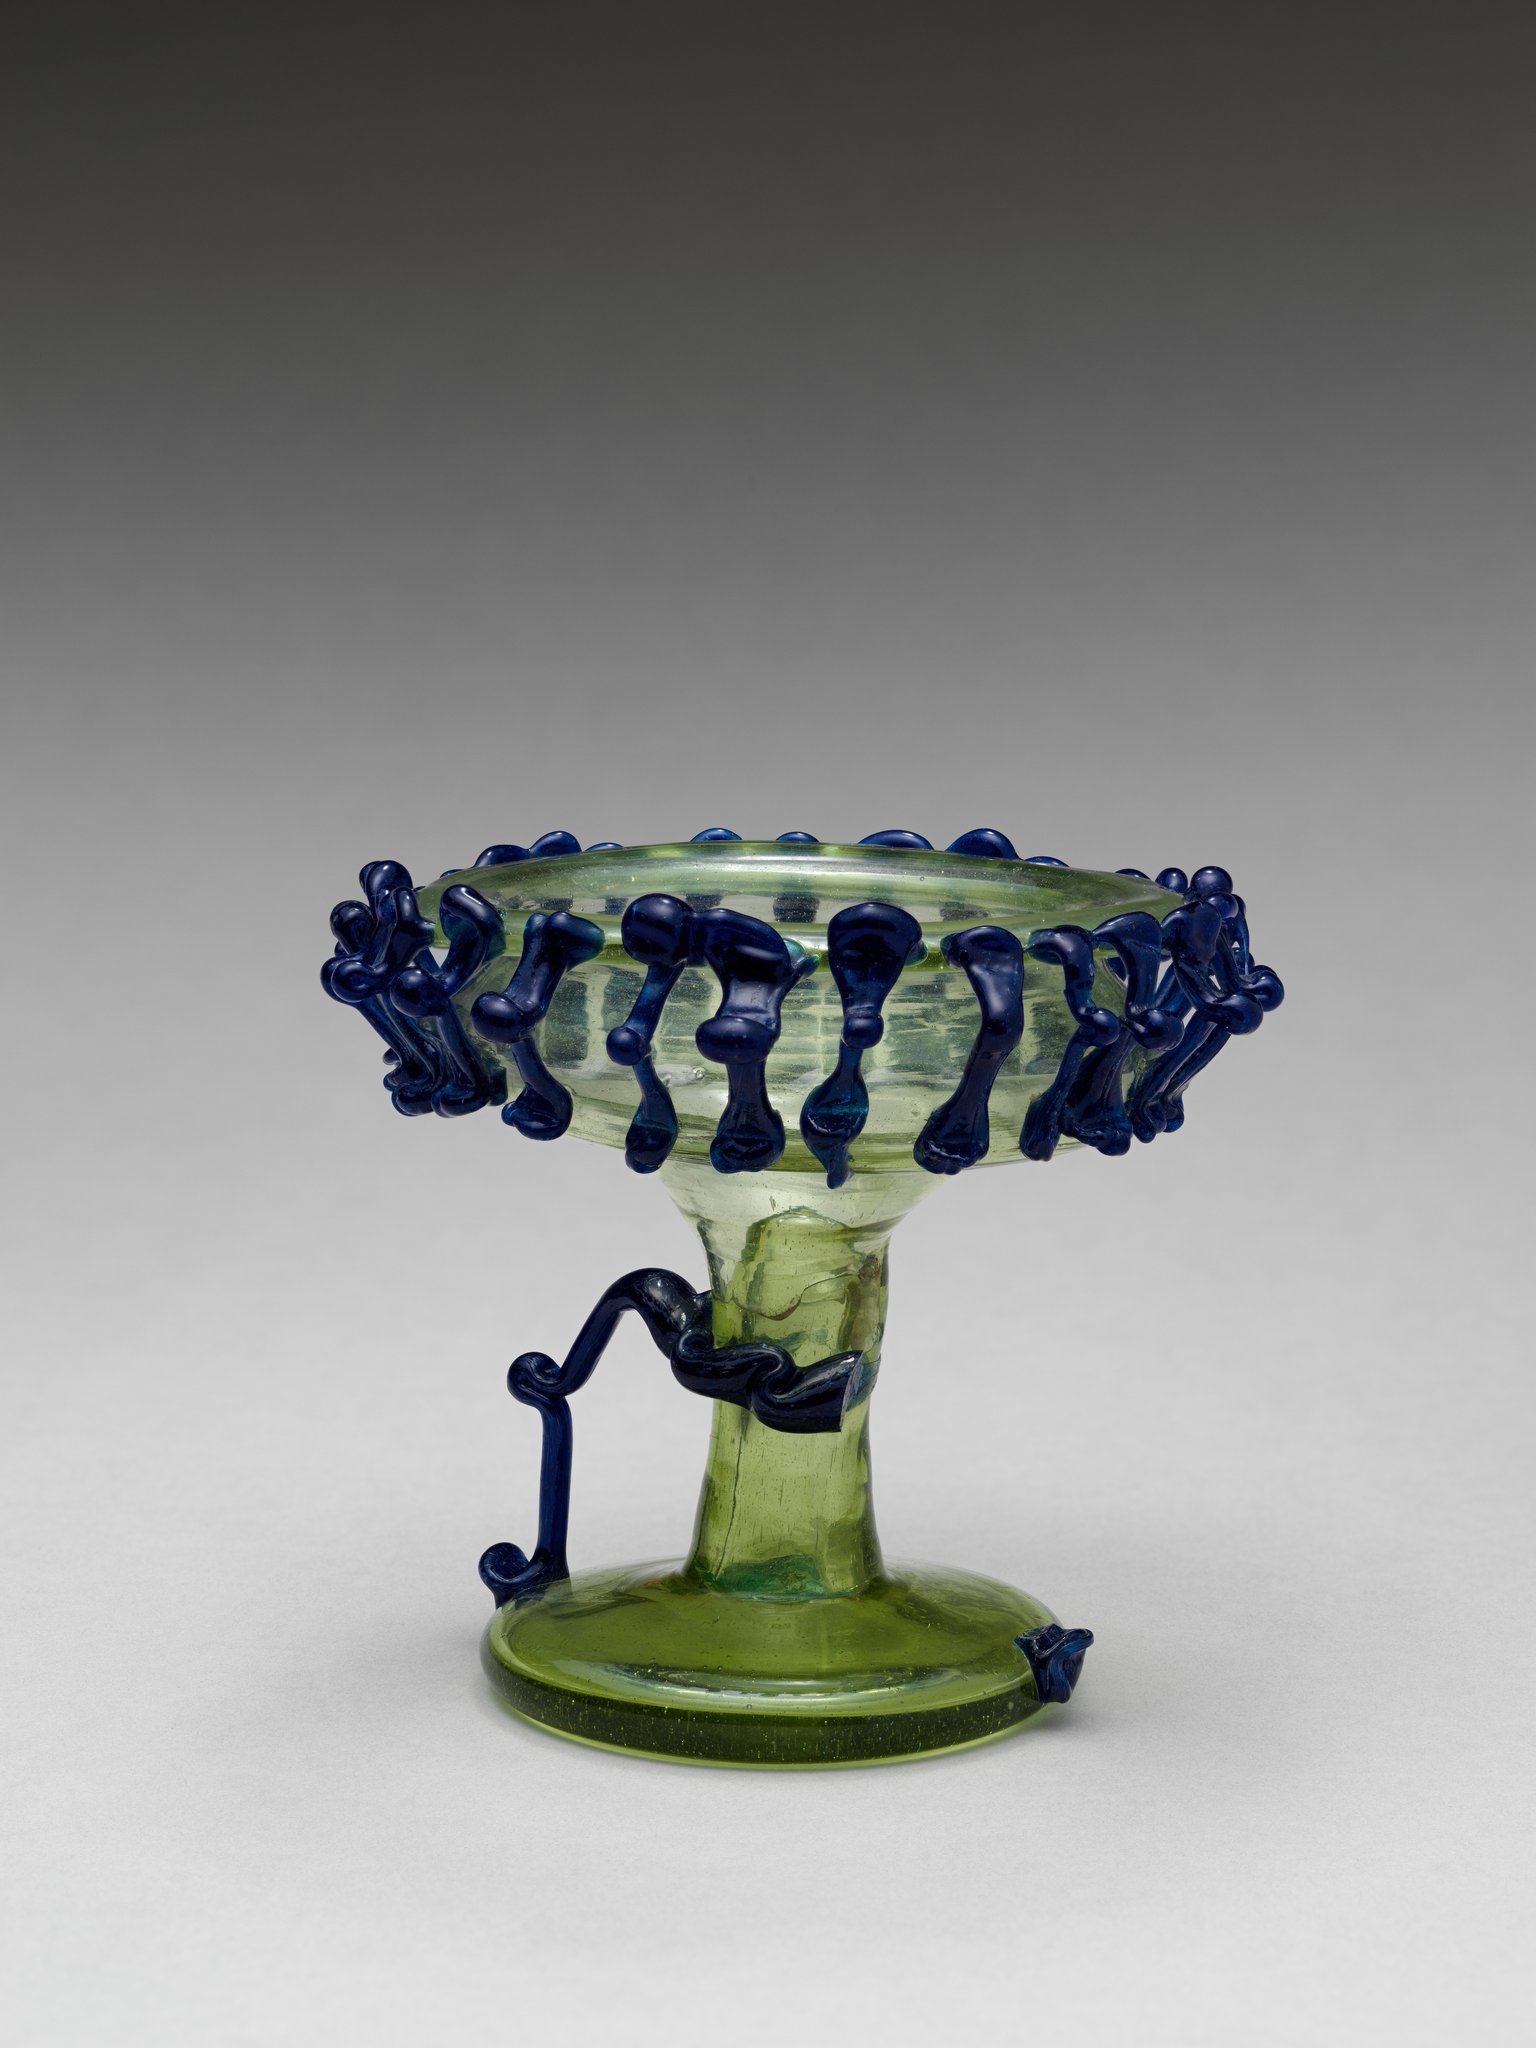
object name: saltcellar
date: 1701-1800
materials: glass